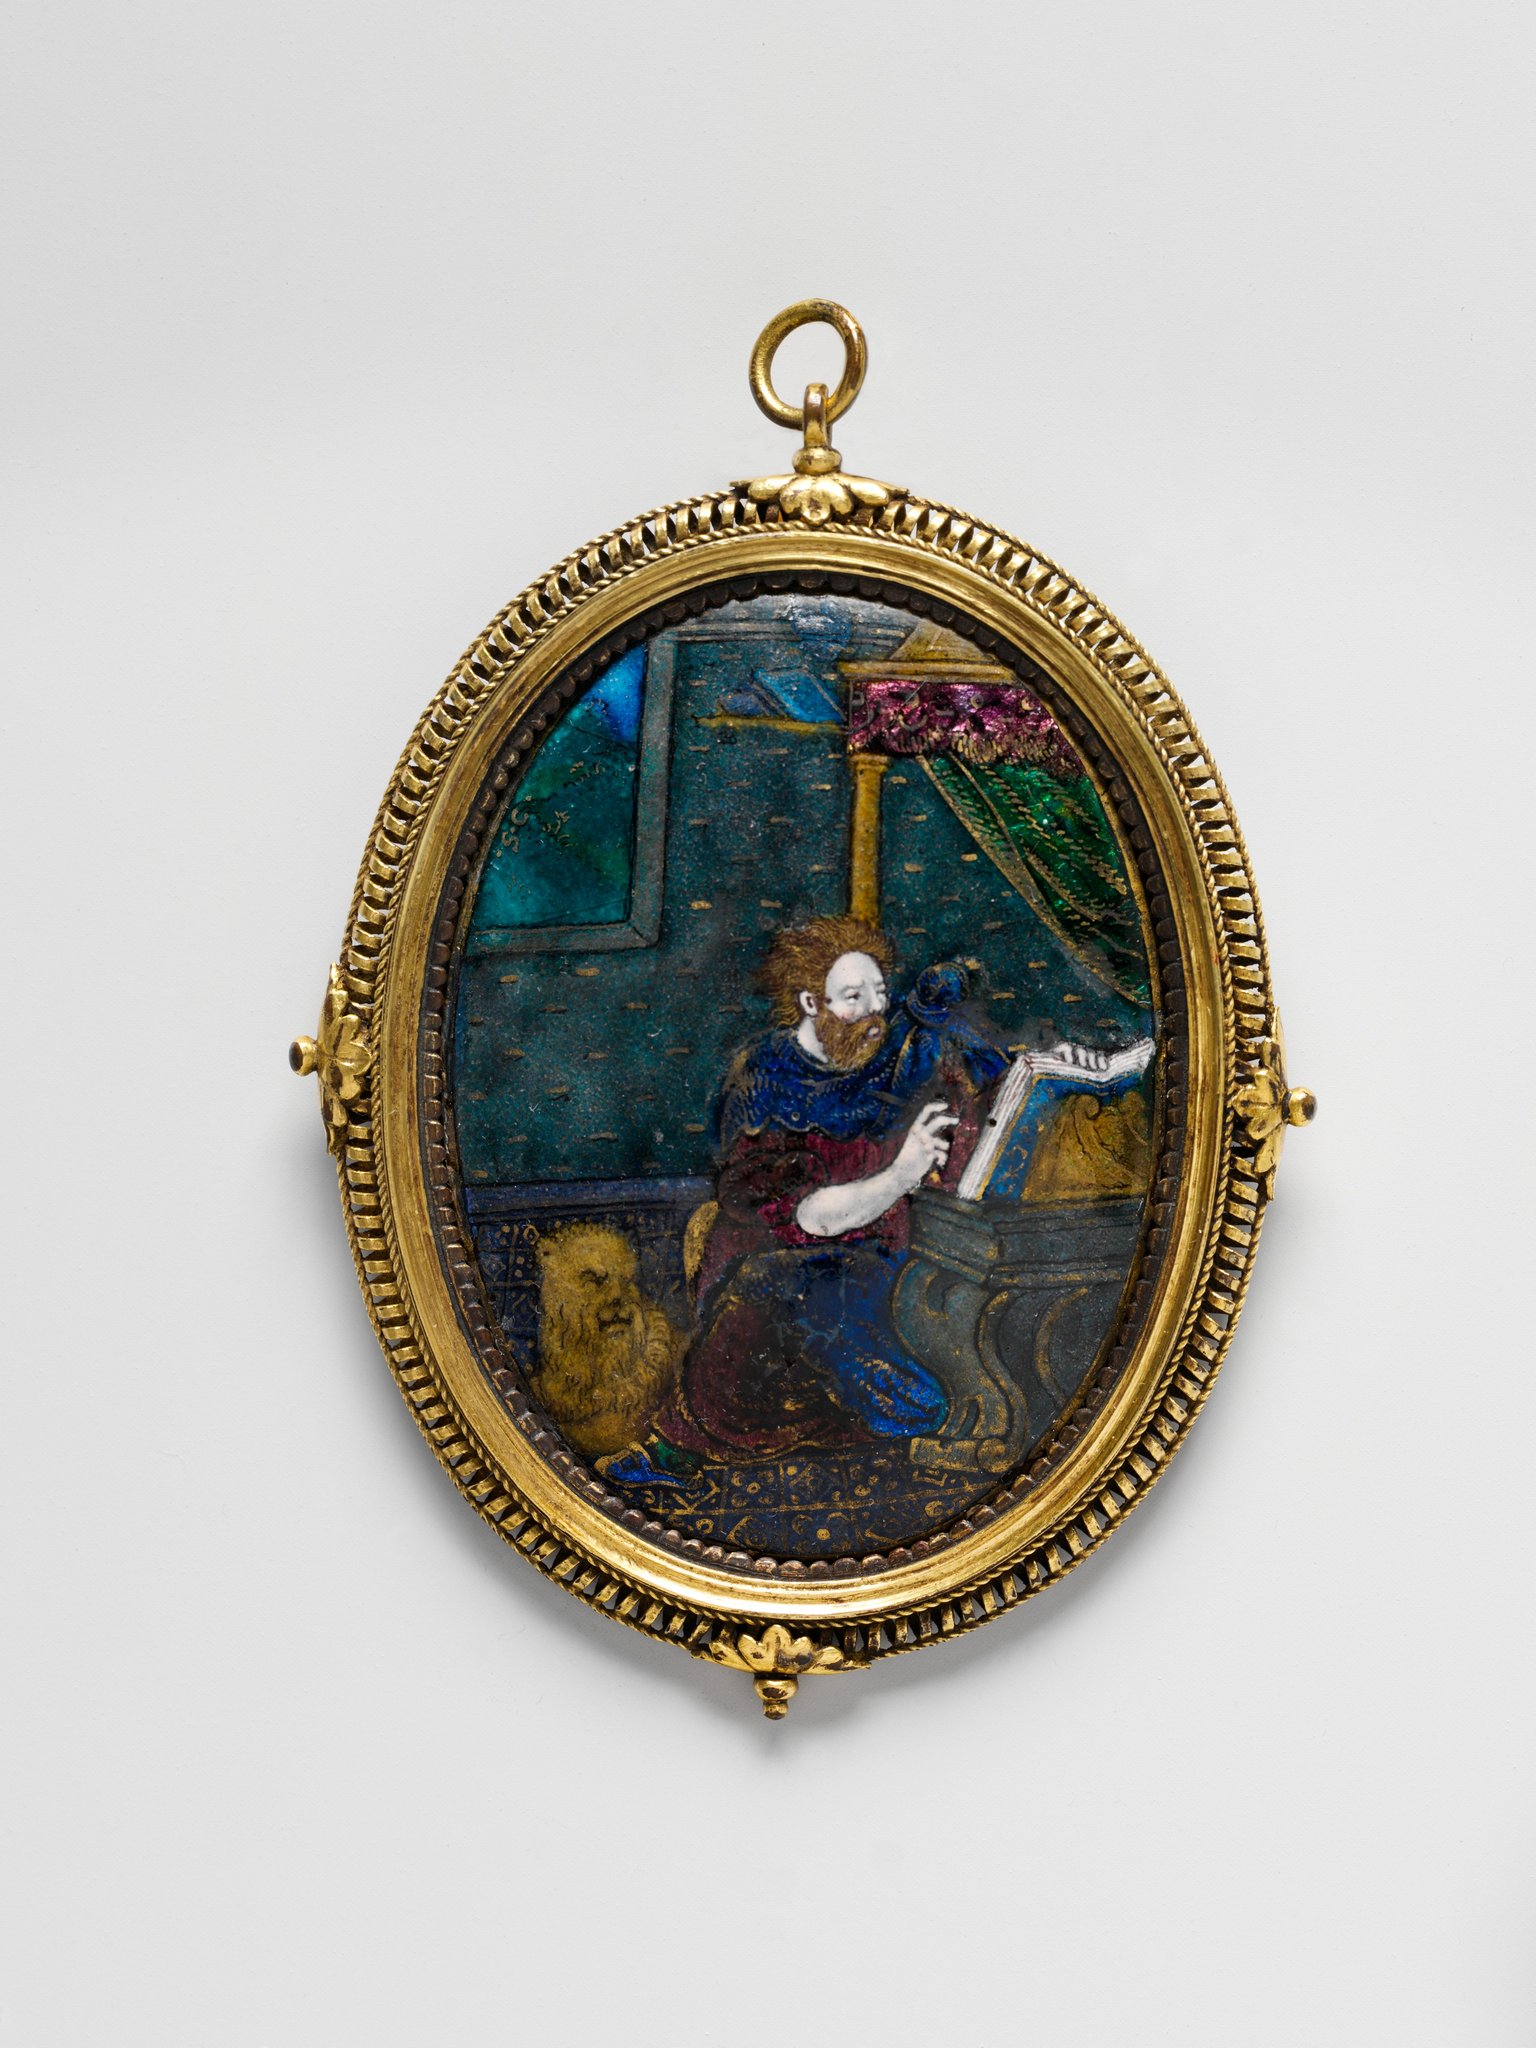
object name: medallion or mirror back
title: St. Mark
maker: suzanne de court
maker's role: enameler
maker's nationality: french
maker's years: 1575-1625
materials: copper, enamel, gilt, metal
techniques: painting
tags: men,lions,saint mark